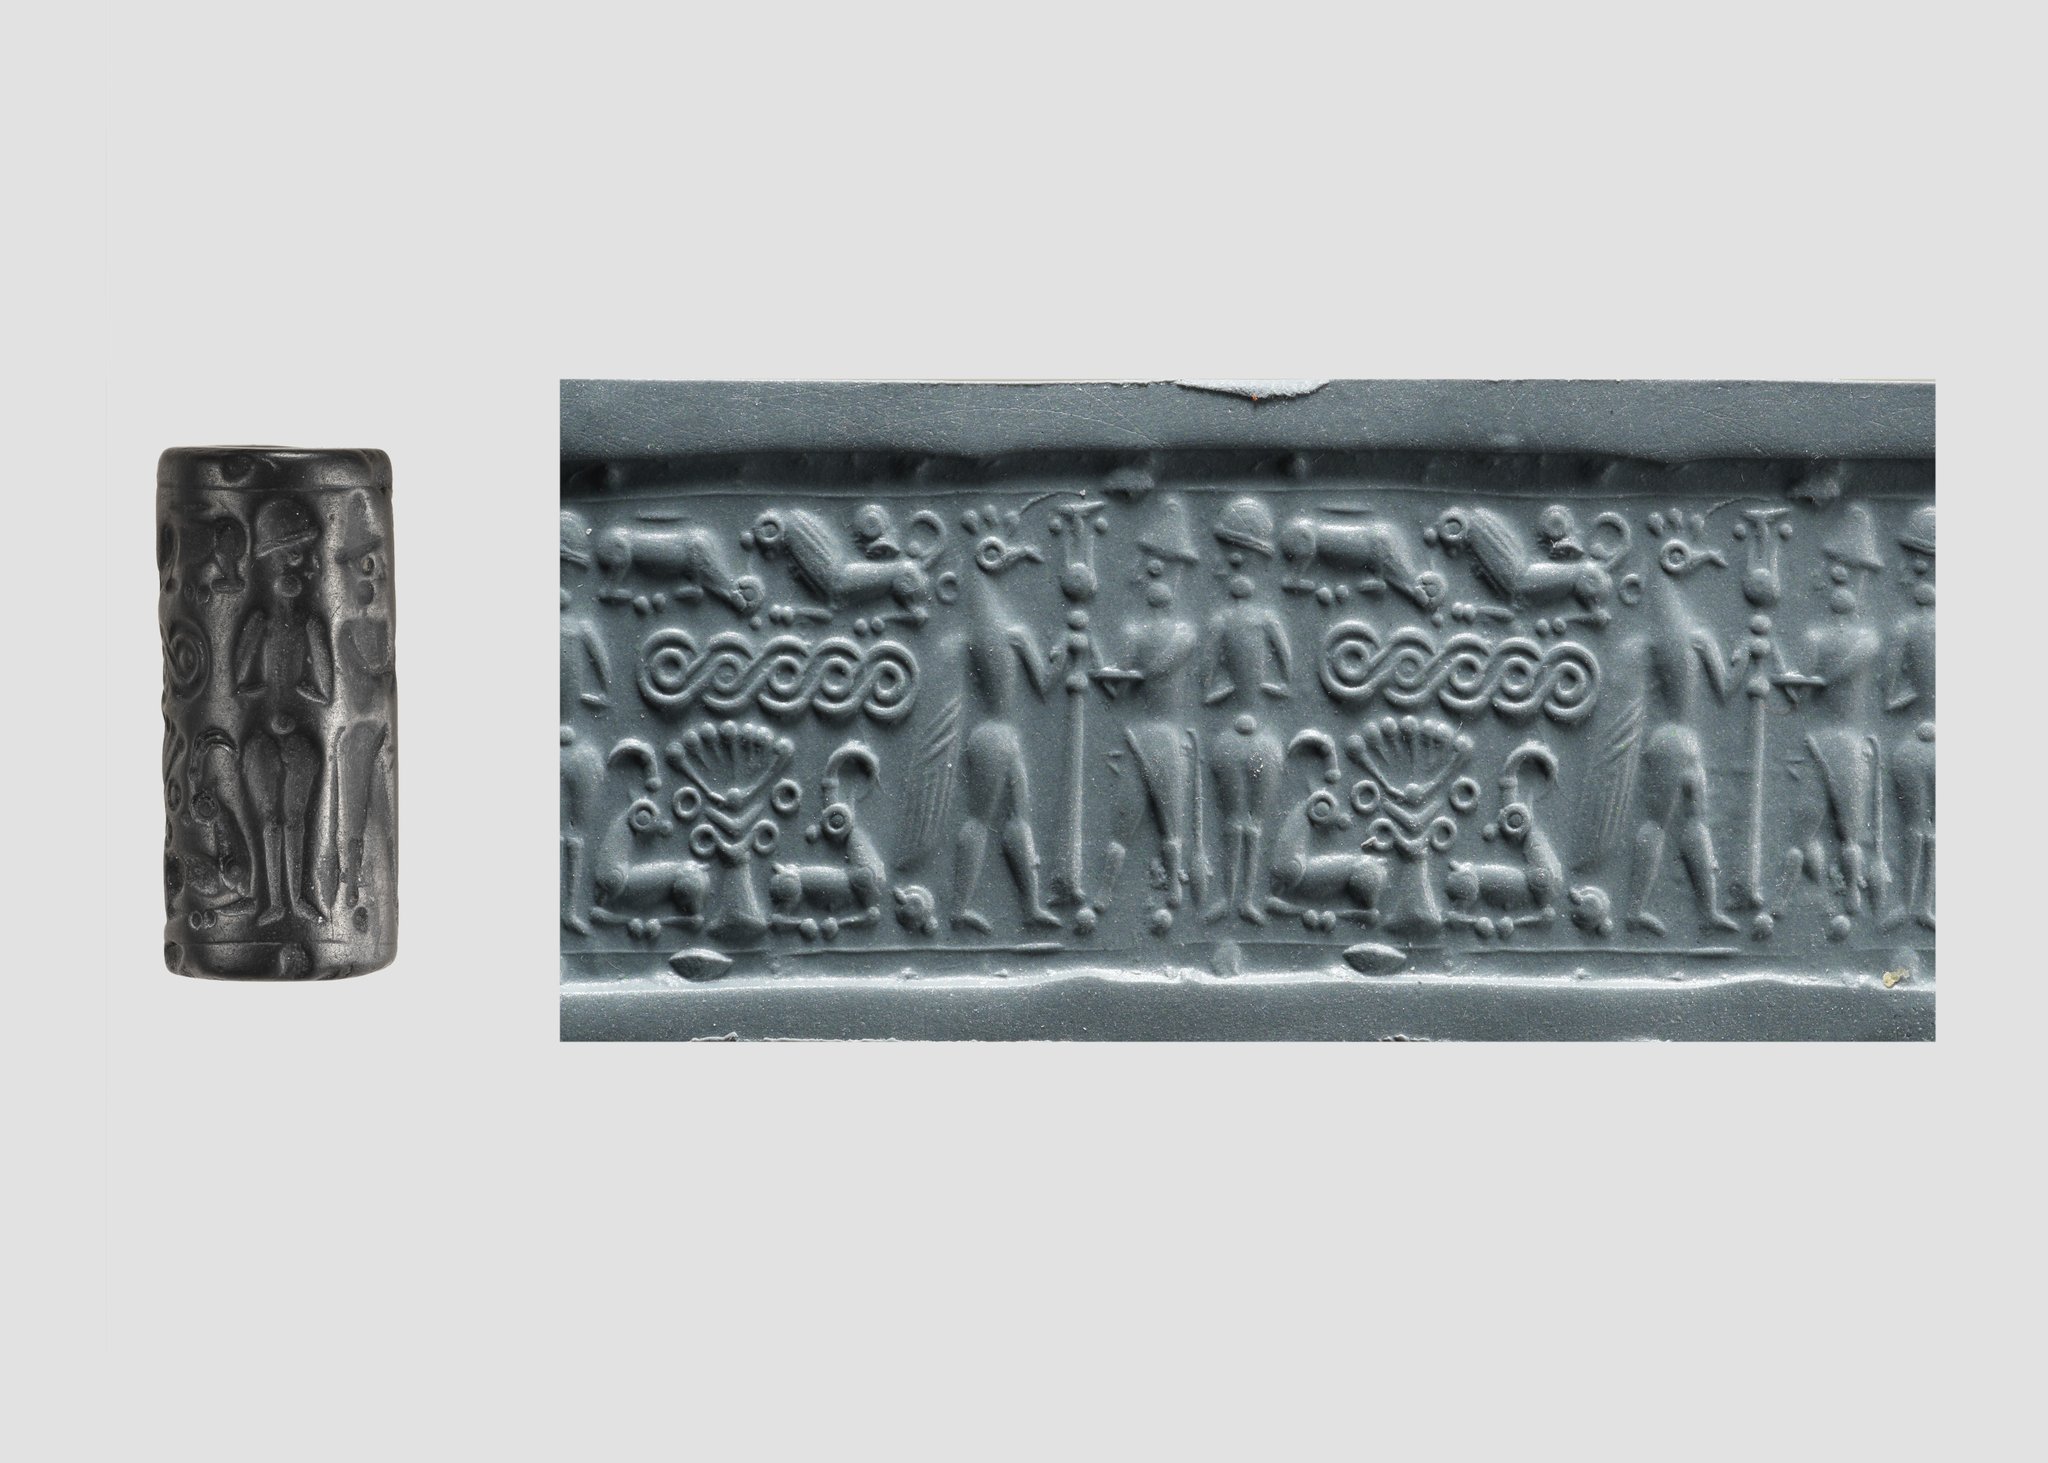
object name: cylinder seal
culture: mitanni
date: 1500-1301 BCE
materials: mineral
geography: mesopotamia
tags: lions,ibex